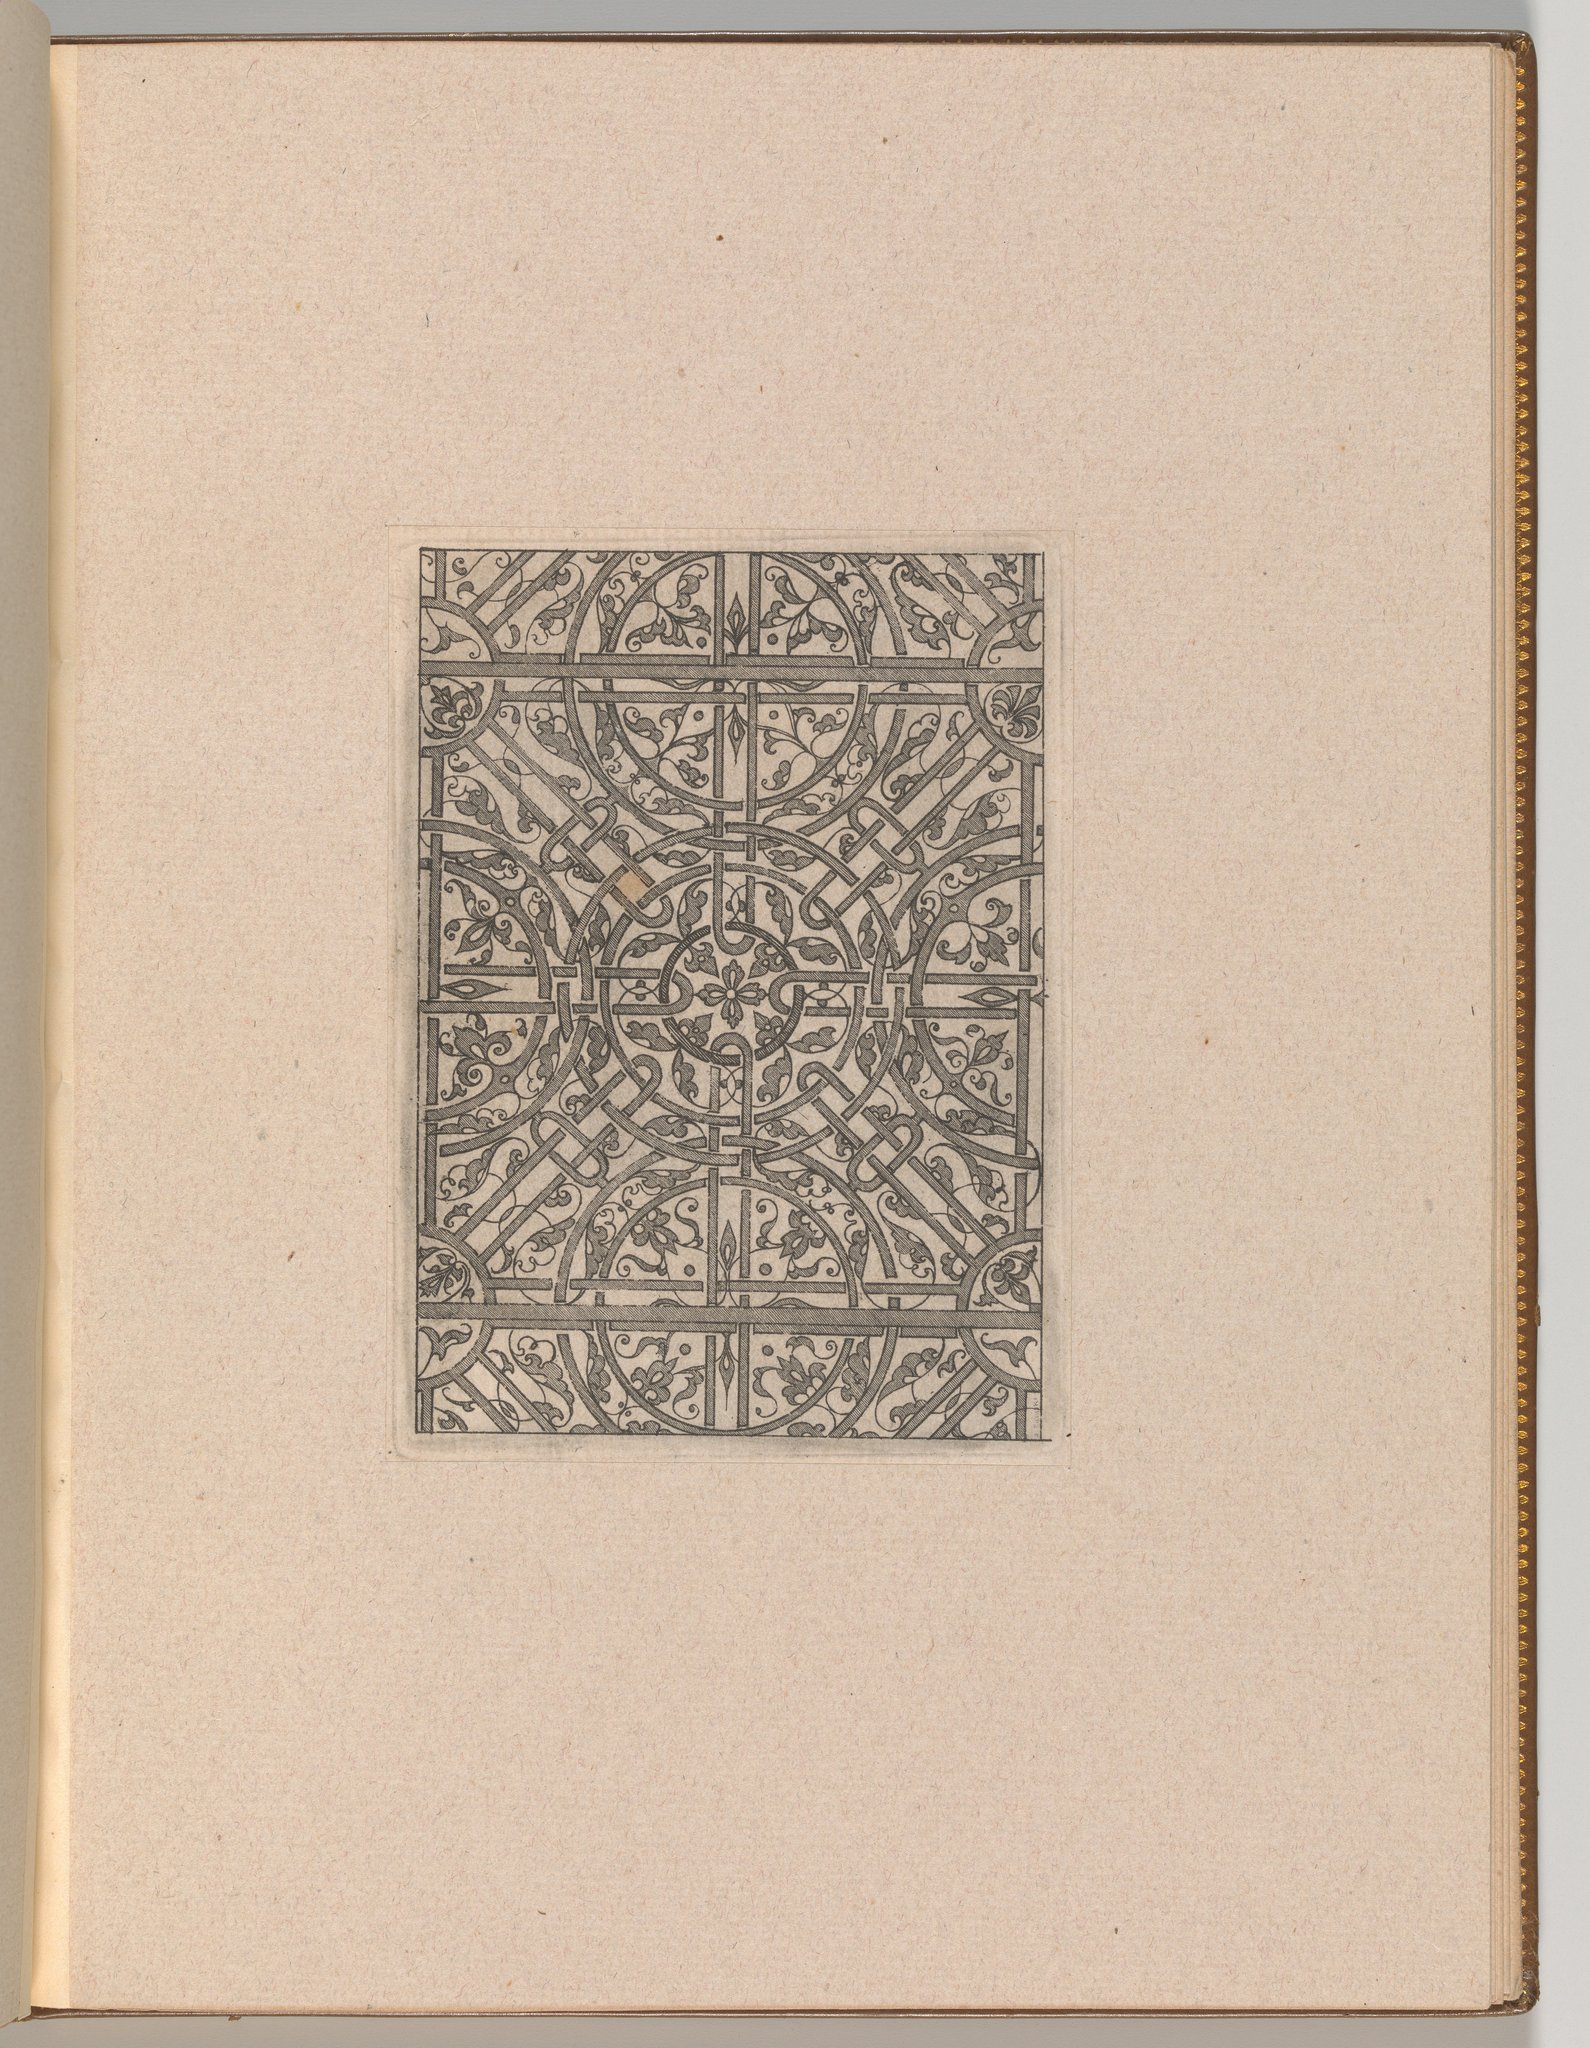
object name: album print ornament architecture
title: Copies after the 'Livre contenant passement de moresques' (plate 2)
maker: jacques androuet du cerceau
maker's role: artist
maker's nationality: french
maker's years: 1510-1585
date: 1801-1900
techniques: etching